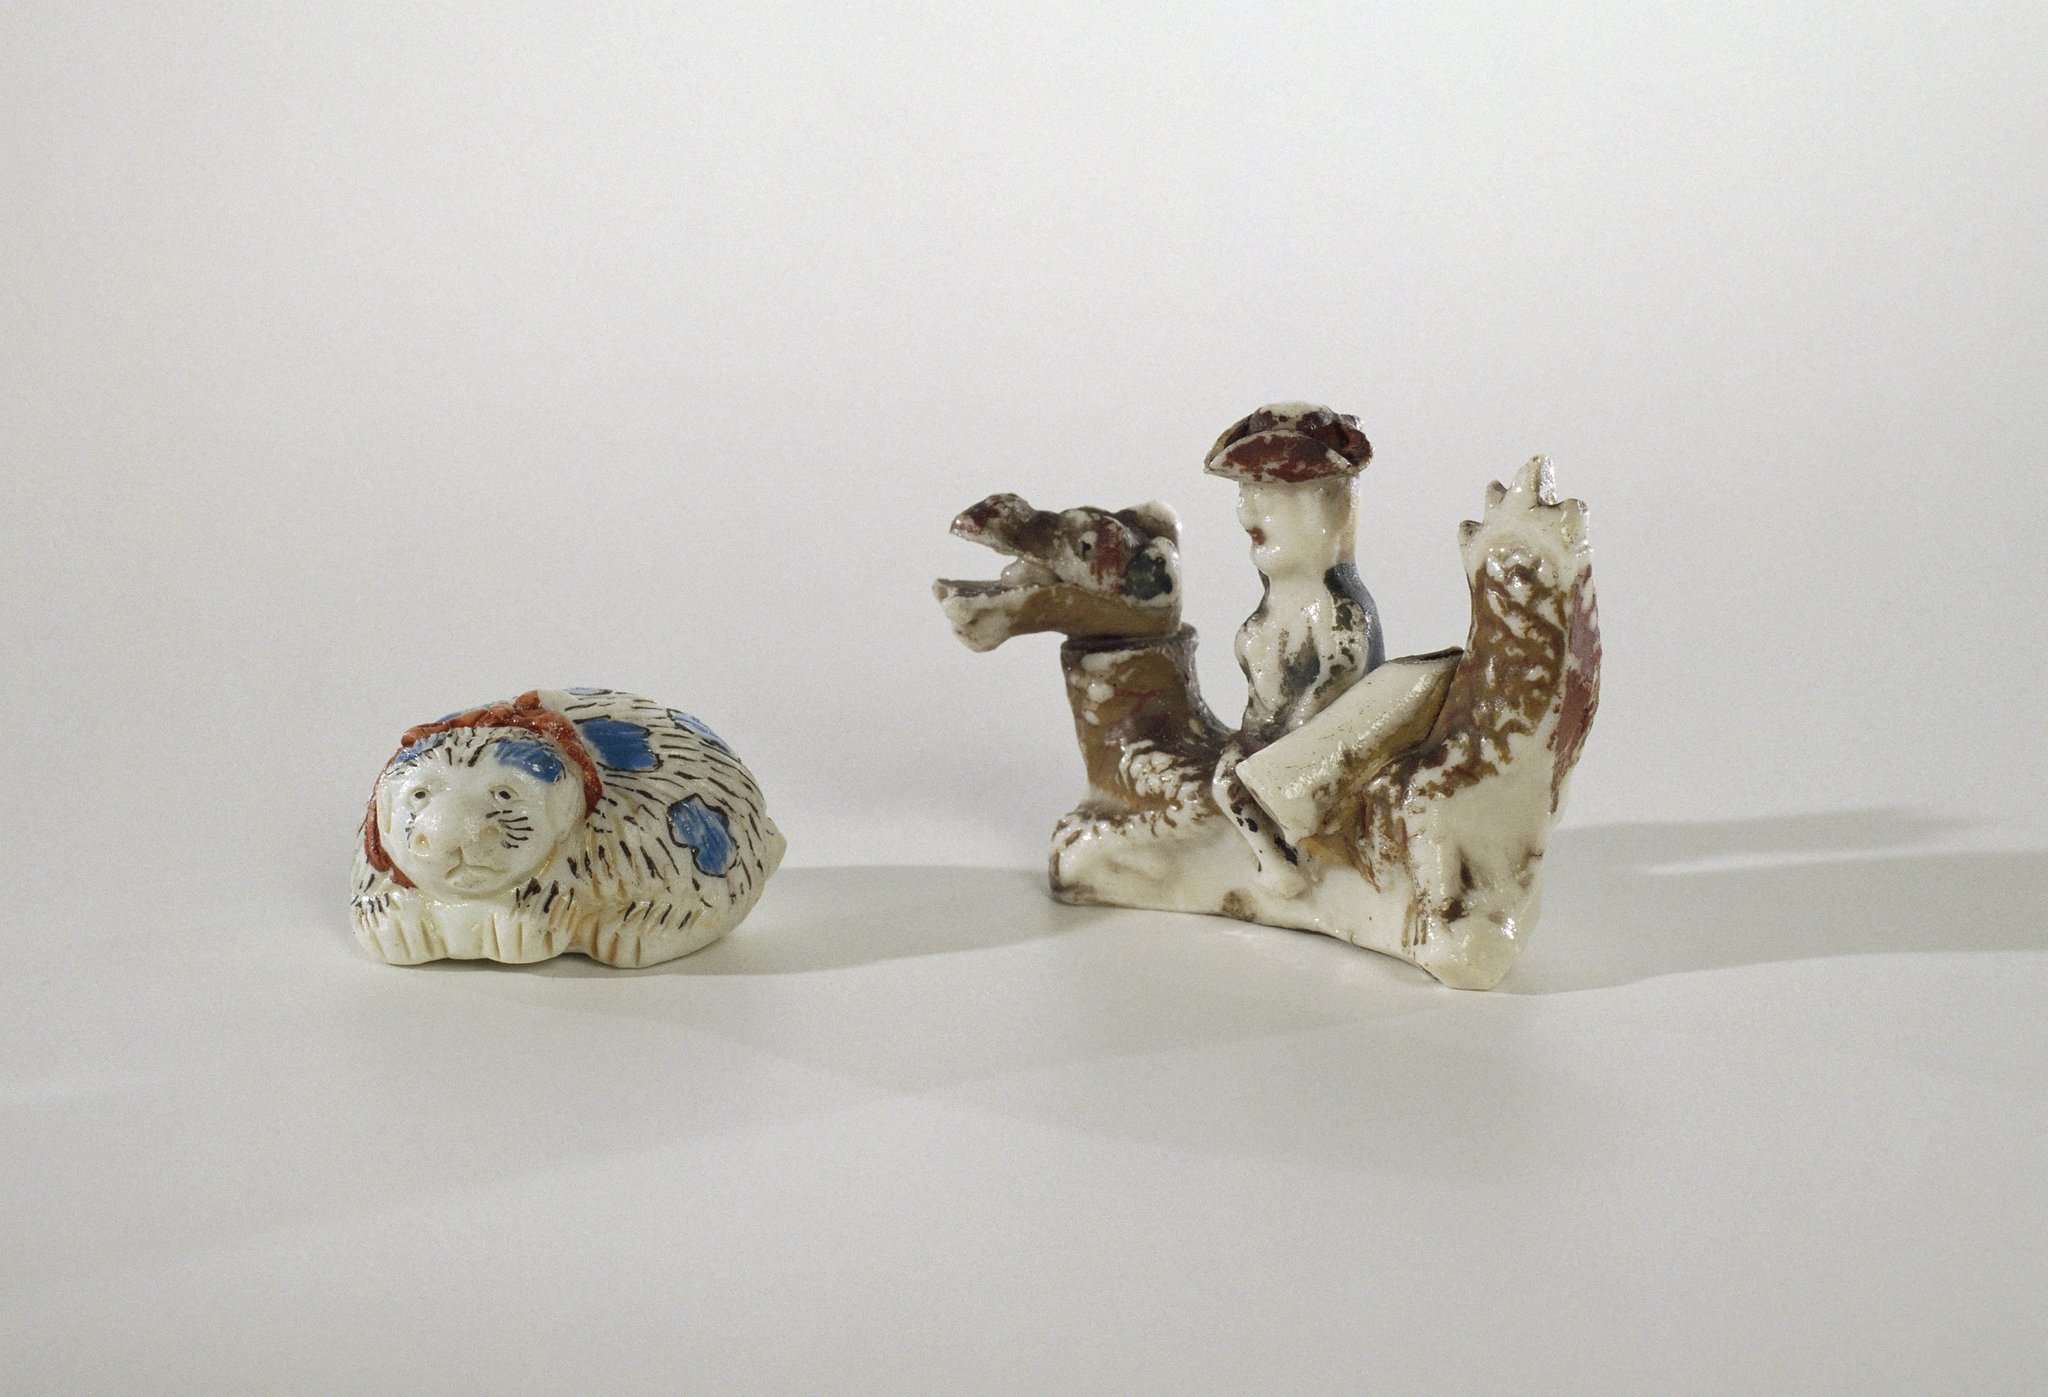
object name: netsuke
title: Netsuke in the shape of a reclining animal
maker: Anonymous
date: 1700-1724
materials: glaze, paint, porcelain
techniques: engraving, firing, forming, vitrification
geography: arita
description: Netsuke van porselein in de vorm van een liggend dier, beschilderd op het glazuur in blauw, rood en zwart. Het dier heeft een halsband om en de vacht is weergegeven door middel van ingegrifte lijnen. Arita.